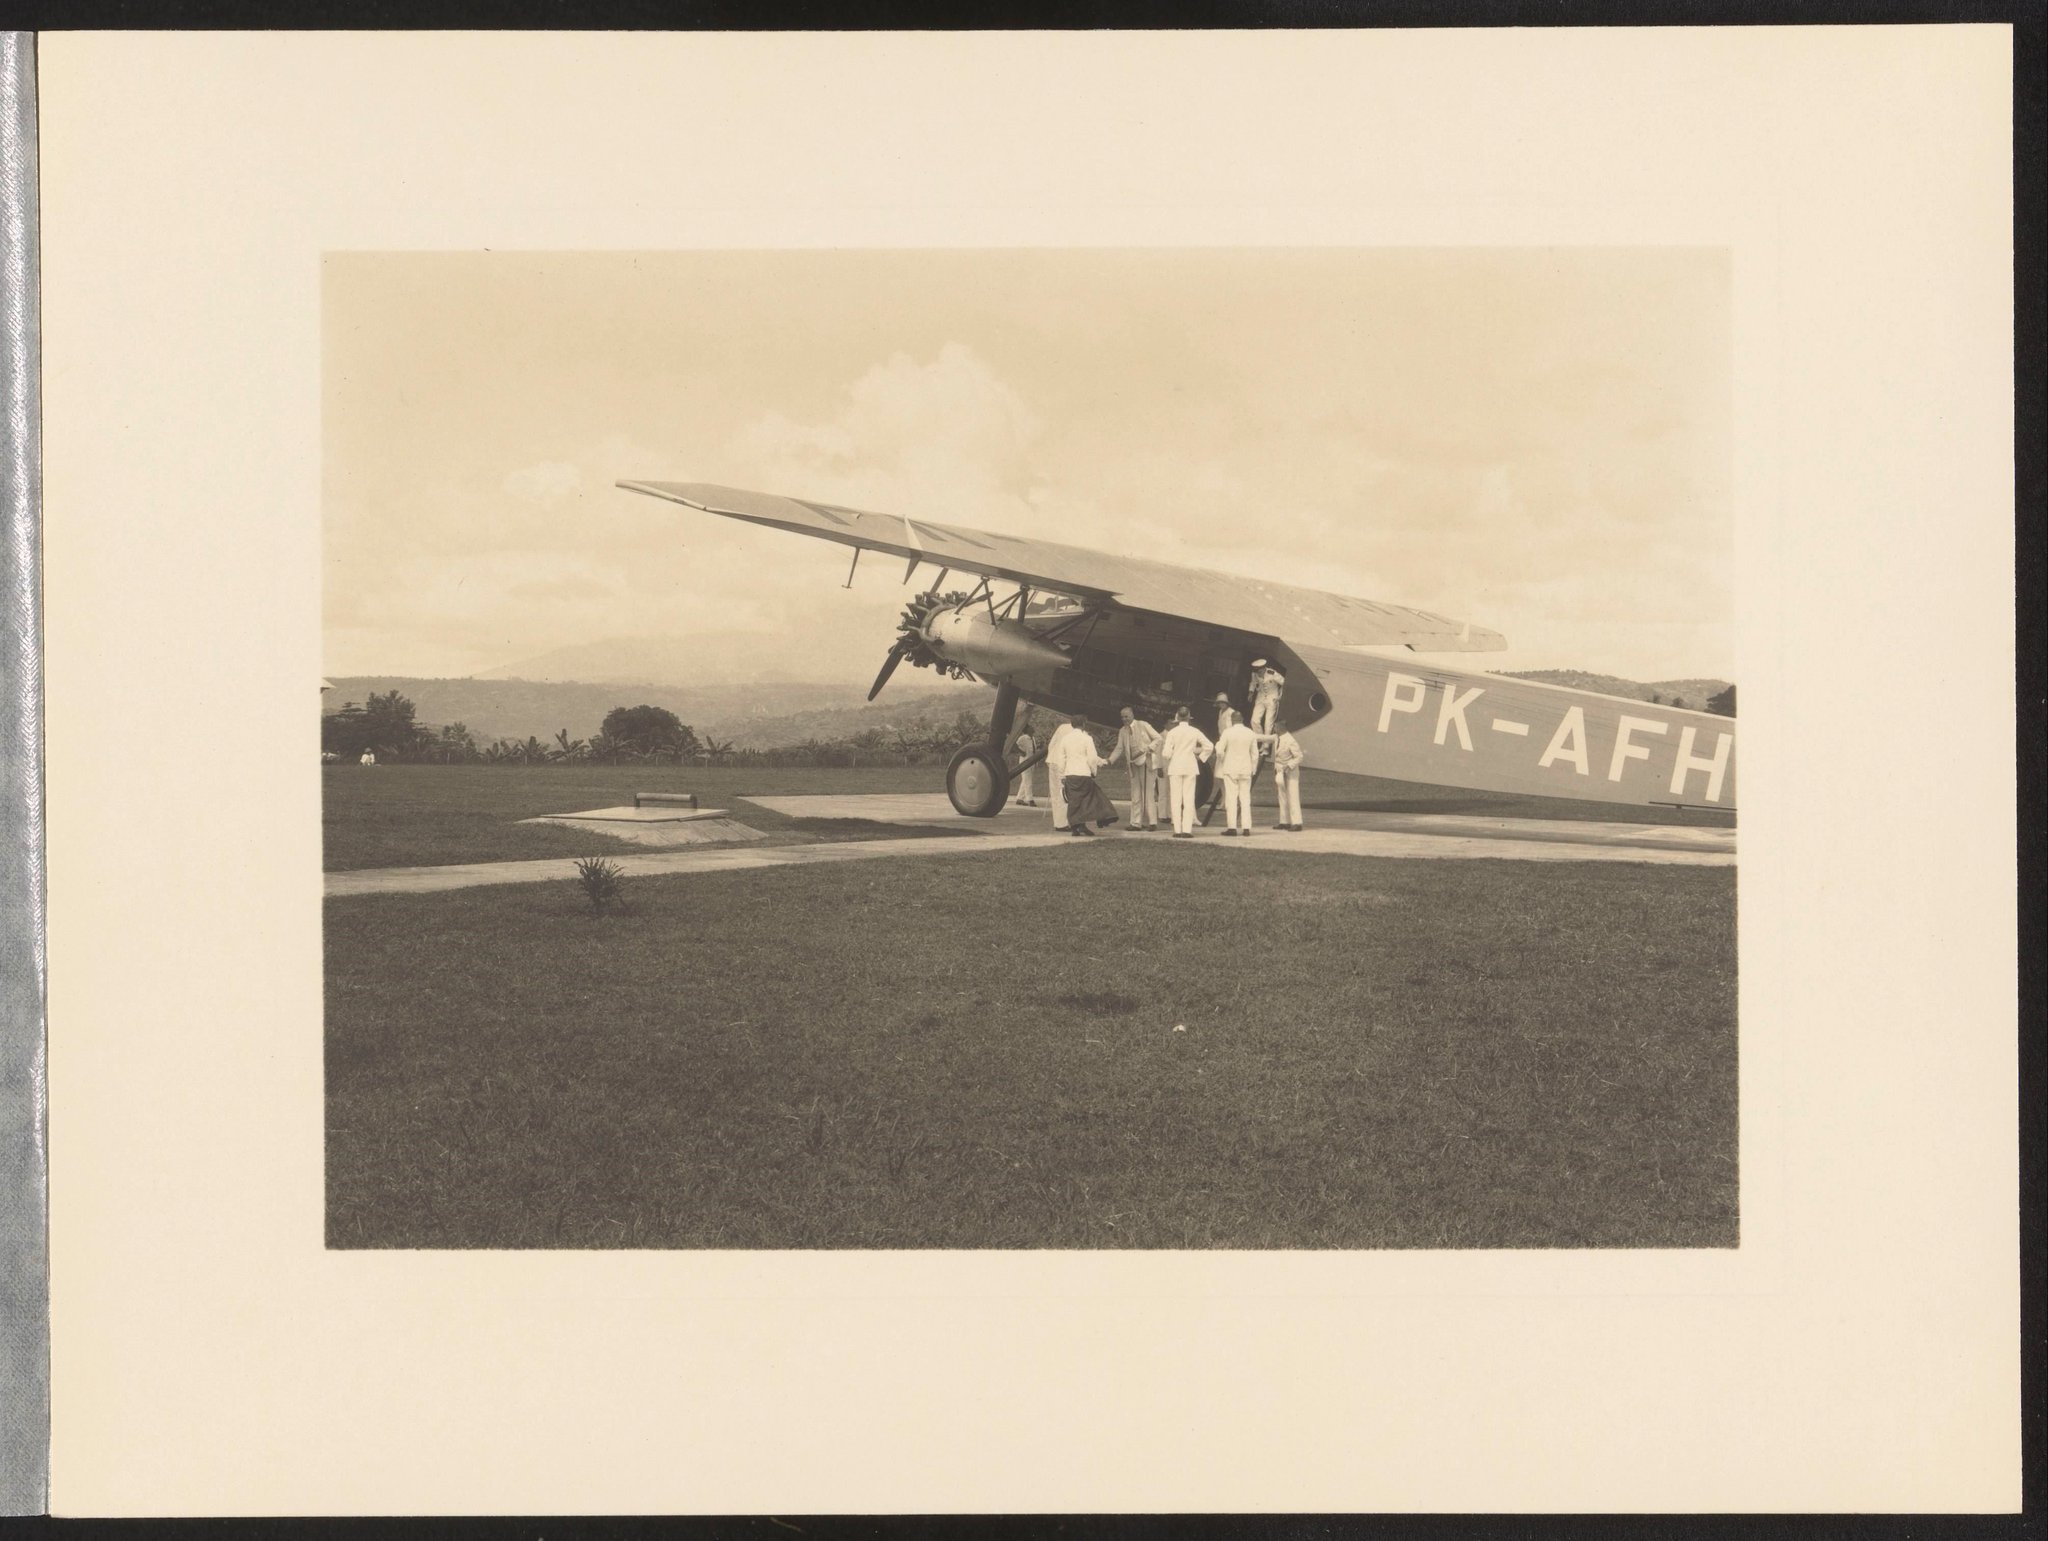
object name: photograph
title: Aankomst van het vliegtuig met de delegatie van gouverneur A.H. Neijs voor een bezoek aan de leprozerie Pelantoengan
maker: otto hisgen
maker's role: fotograaf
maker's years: 1874-1944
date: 1905-1931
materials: photographic support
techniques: photography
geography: semarang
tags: the hague, leprosarium, aircraft, aeroplane, colonial government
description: Aankomst van het vliegtuig van de Koninklijke Nederlandsch-Indische Luchtvaart Maatschappij met de delegatie van gouverneur A.H. Neijs voor een bezoek aan de Semarang-leprozerie in Pelantoengan in mei 1931. Losse foto in de map met herinneringsfoto's van het bezoek aangeboden aan gouverneur A.H. Neijs.